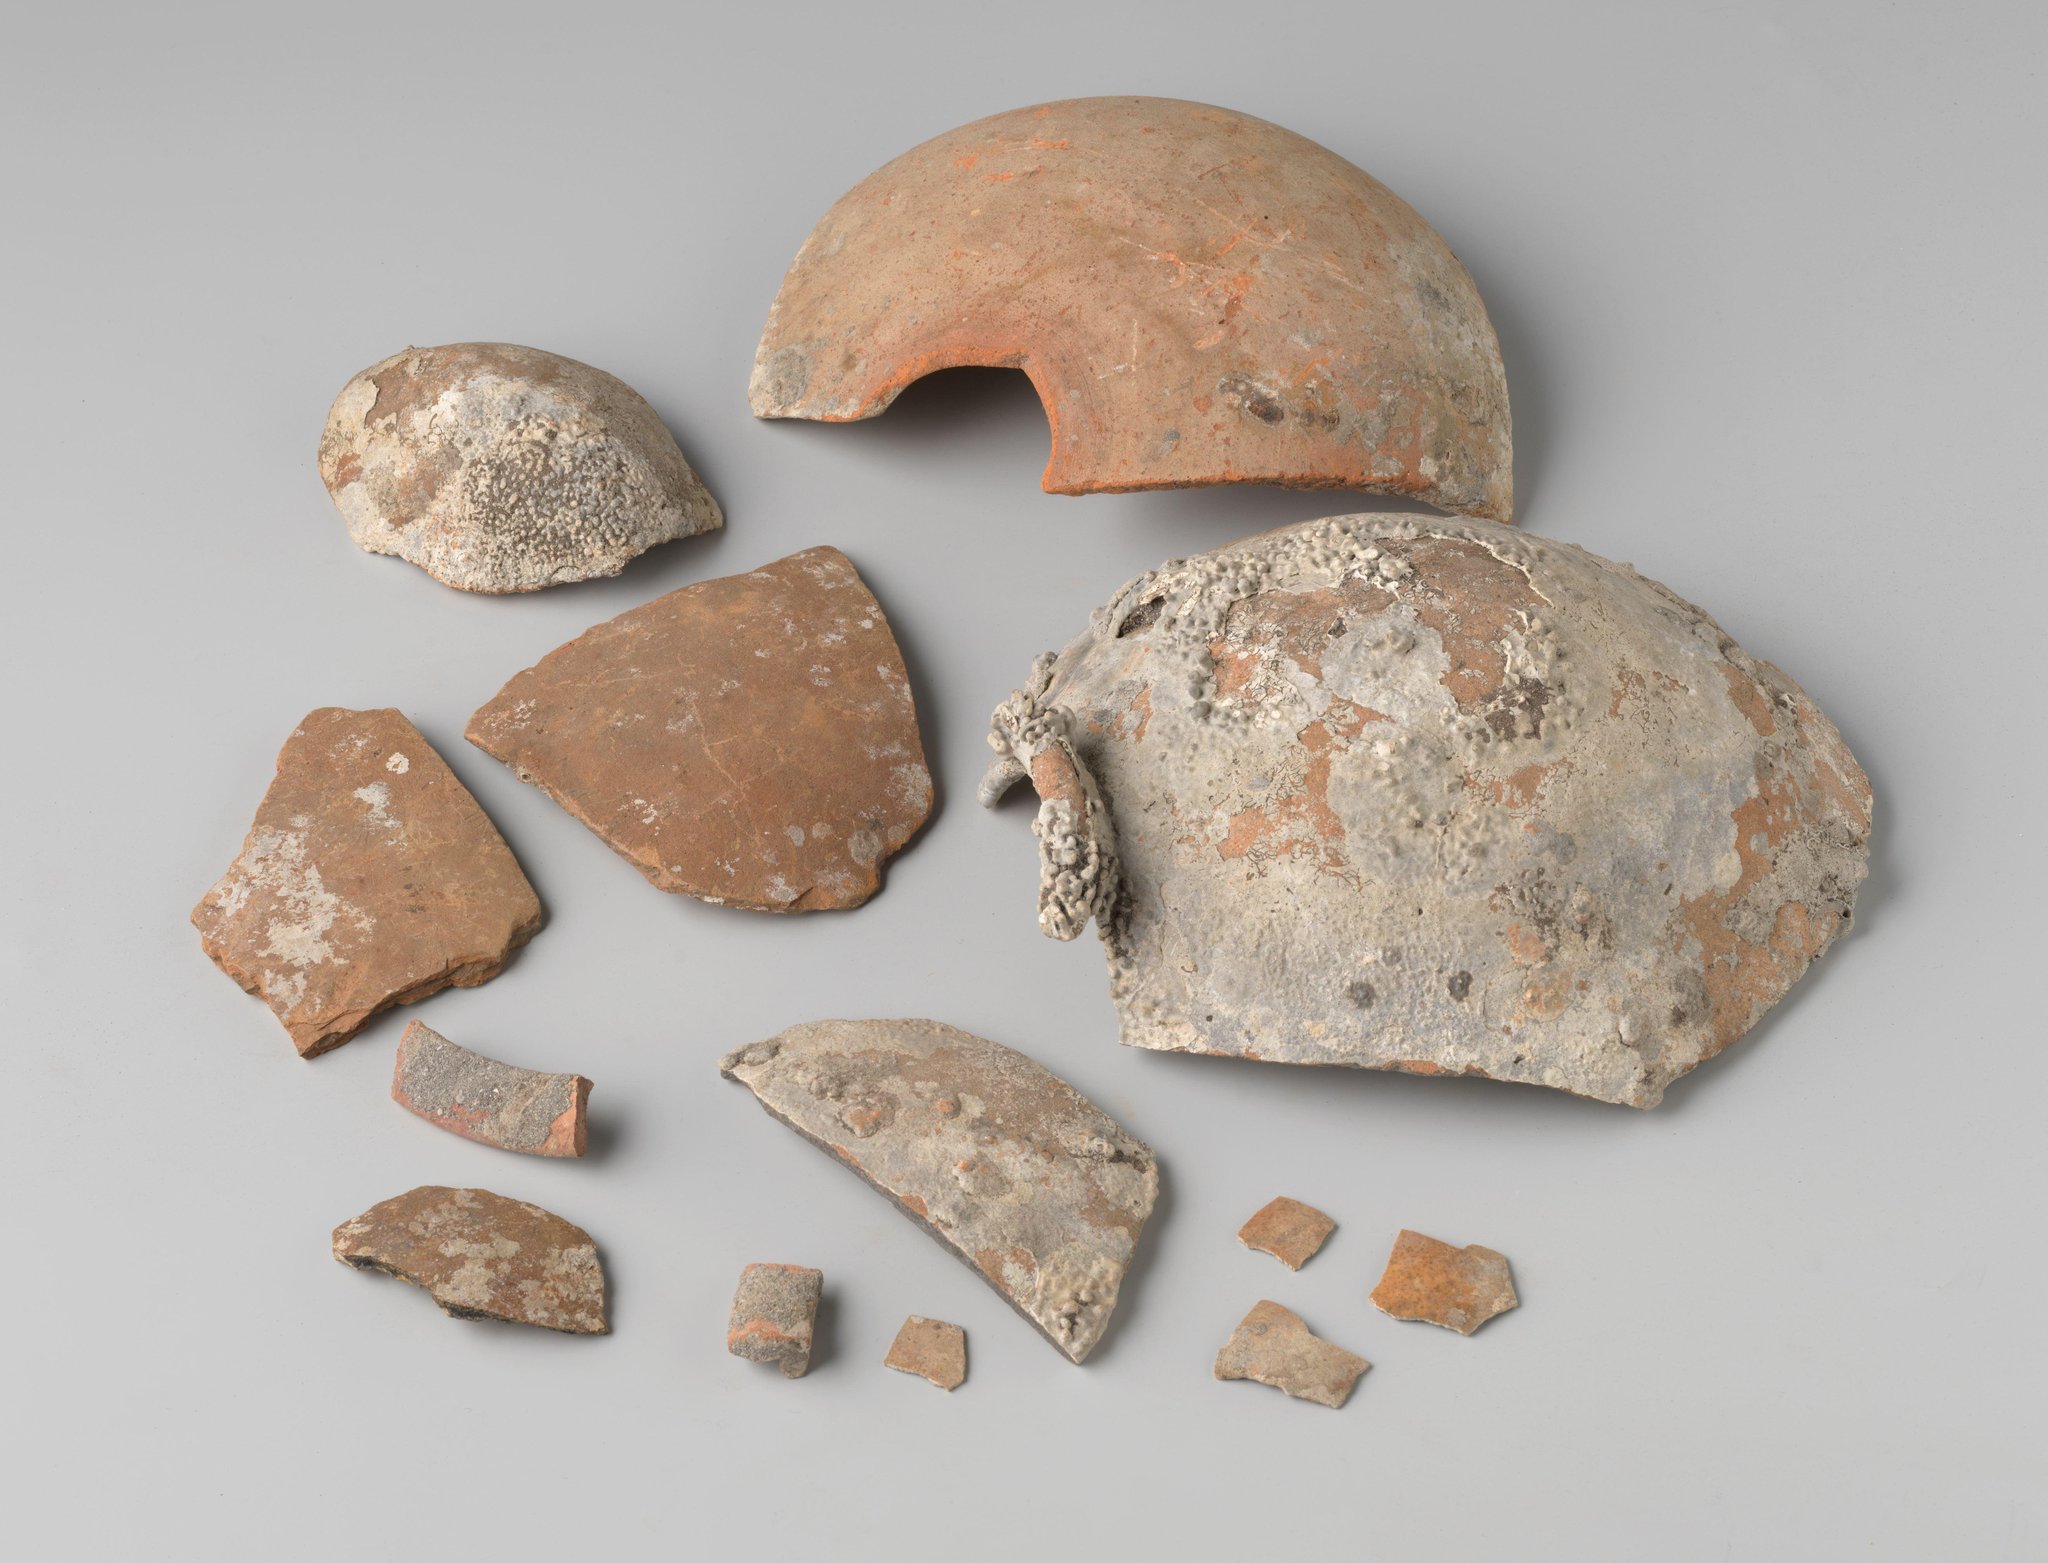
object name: sherd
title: Scherven aardewerk en steengoed uit V.O.C.-schip de 'Witte Leeuw'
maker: Anonymous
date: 1613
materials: earthenware, stoneware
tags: verenigde oostindische compagnie, sint-helena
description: Scherven aardewerk en steengoed uit V.O.C.-schip de 'Witte Leeuw'.